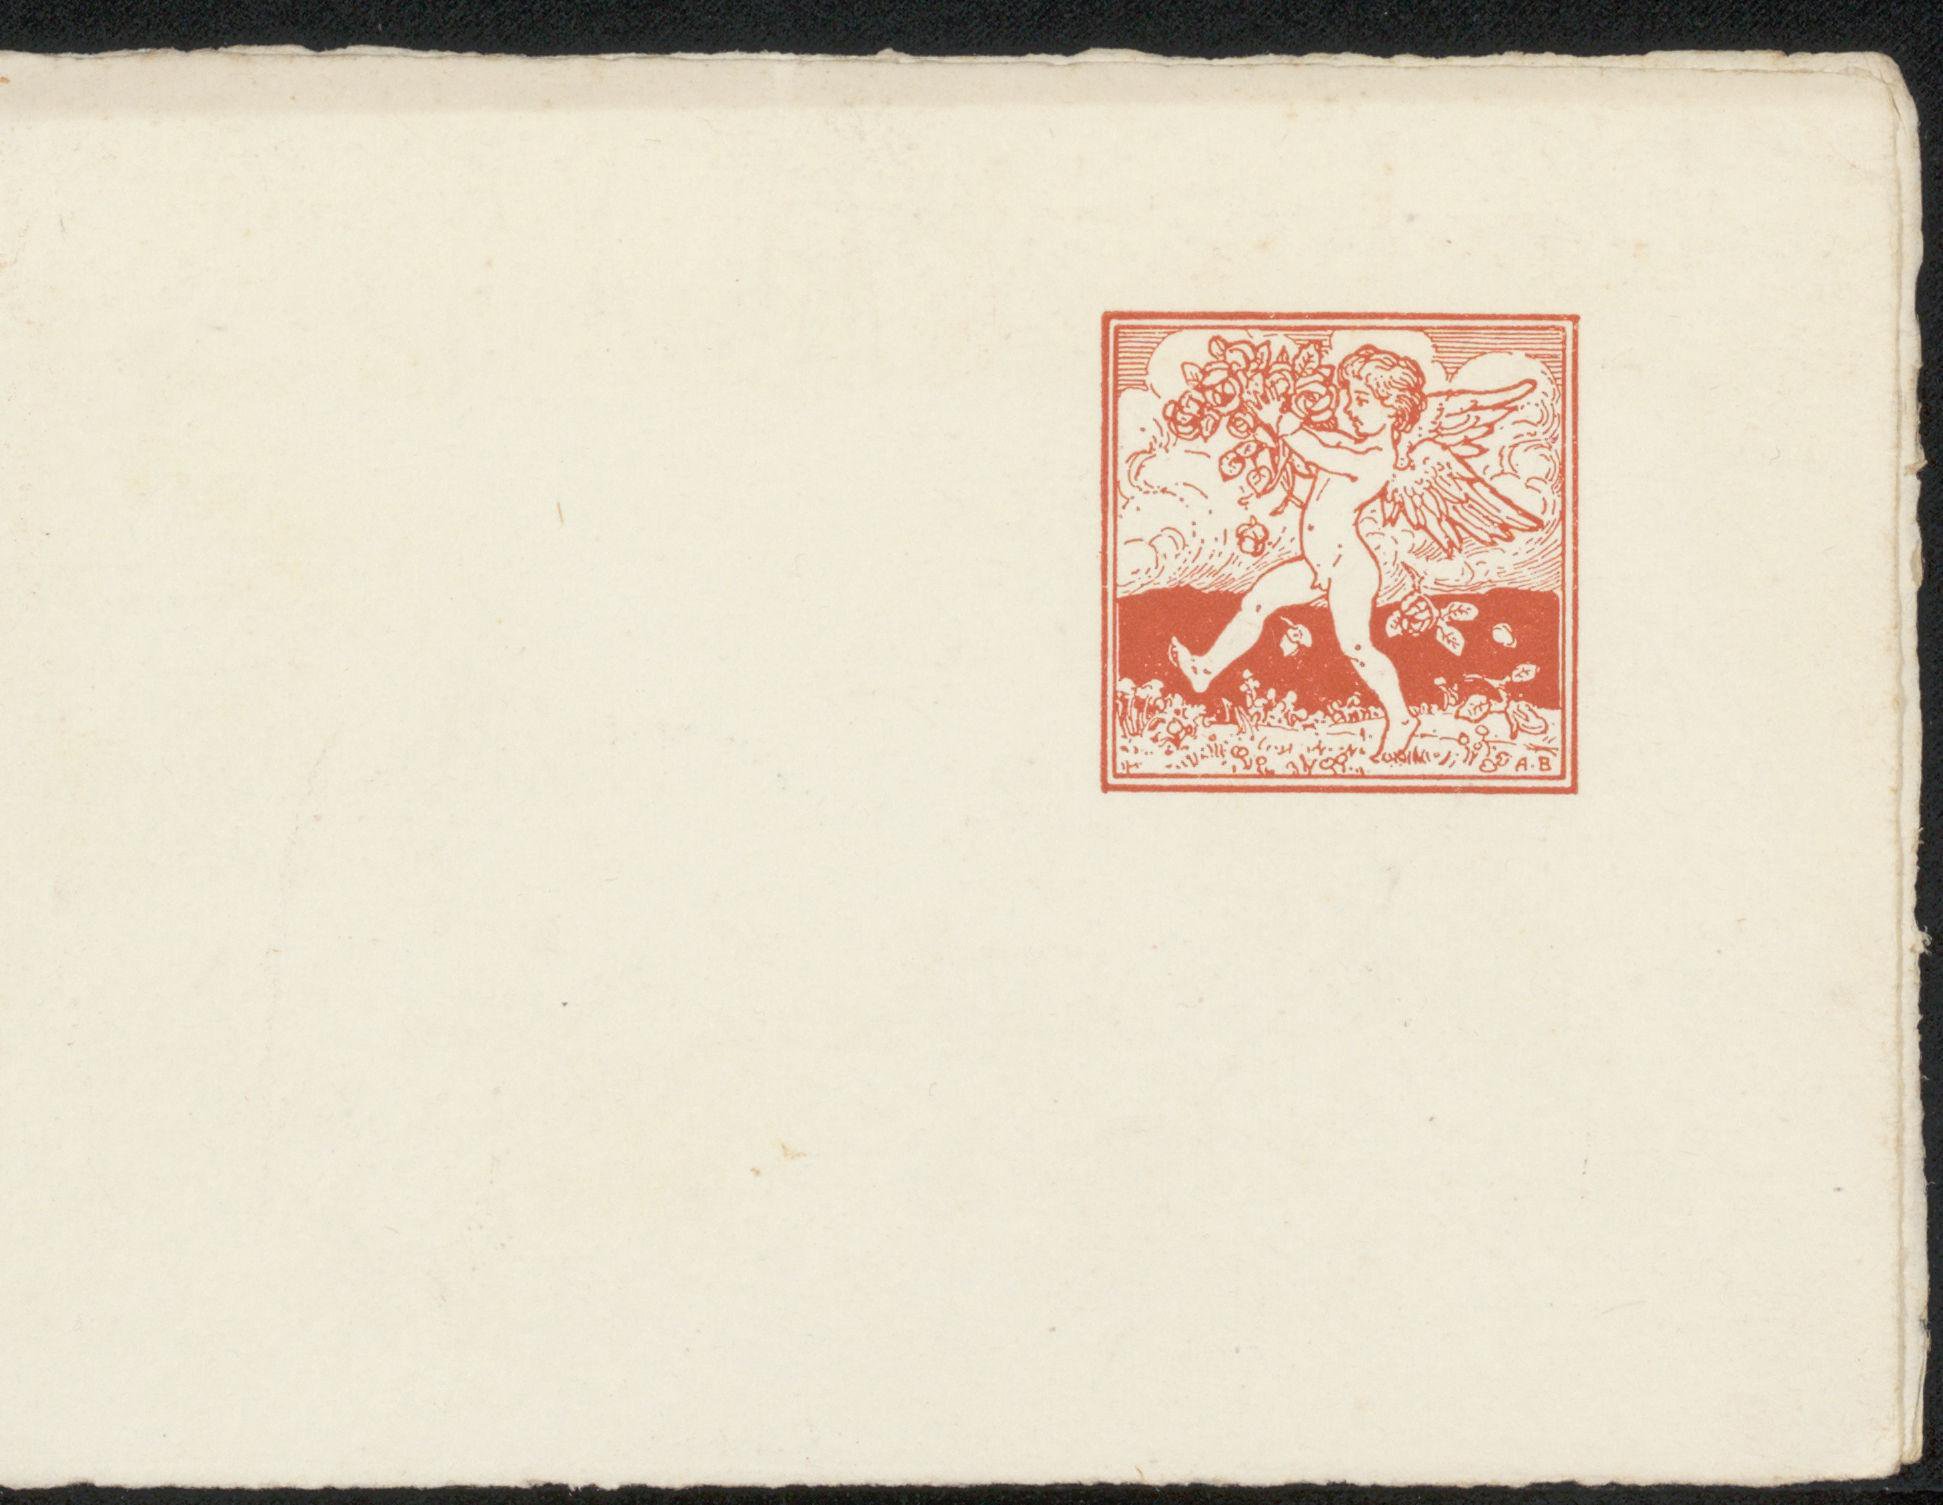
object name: wedding announcement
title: Huwelijksaankondiging uit archief Philip Zilcken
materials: cardboard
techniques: printing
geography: rome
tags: naples, vittorio pica, anna pica-marazzani, the hague, painter, draughtsman, philip zilcken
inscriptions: collector's mark: ‘RPK’